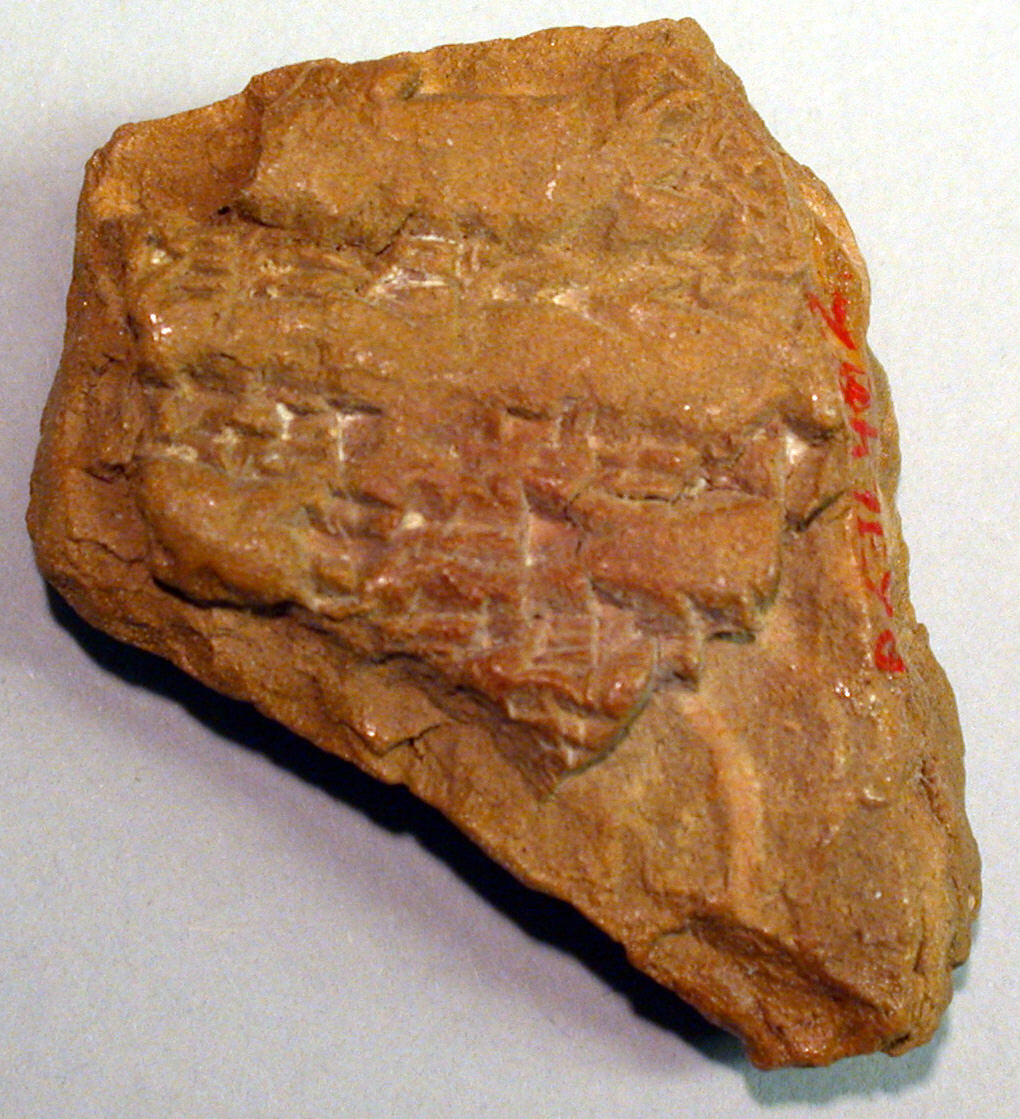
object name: cuneiform tablet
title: Cuneiform tablet: unidentified fragment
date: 333-1 BCE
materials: clay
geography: mesopotamia